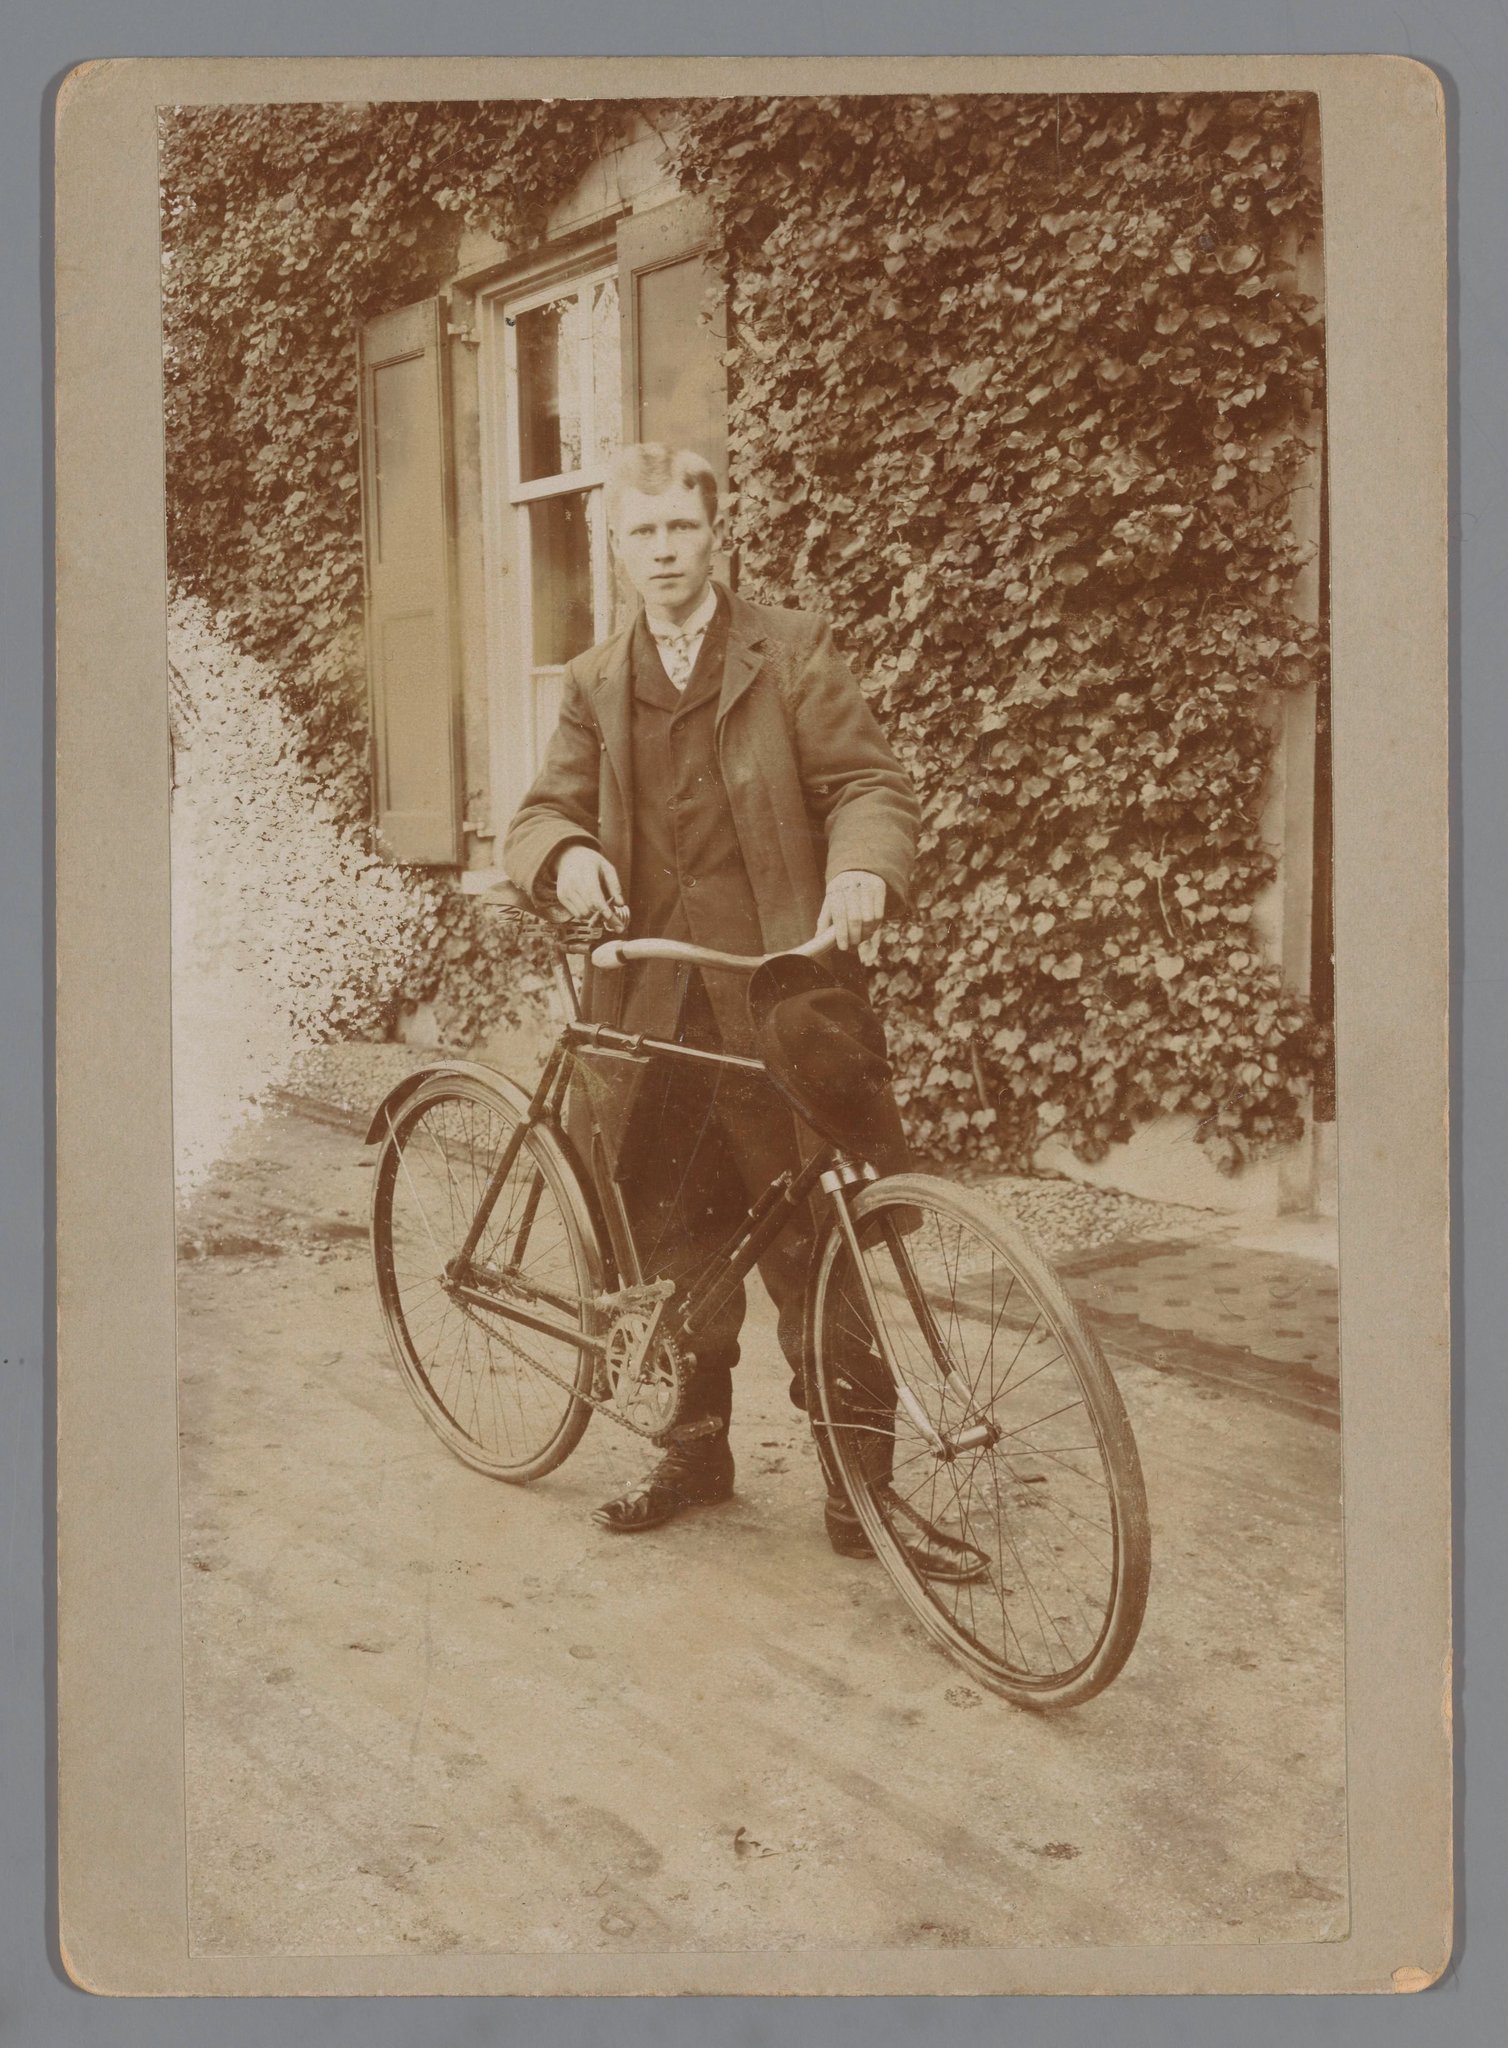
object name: photograph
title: Portret van een onbekende man met een fiets voor een huis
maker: Anonymous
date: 1890-1910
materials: cardboard, photographic support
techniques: gelatin silver print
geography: netherlands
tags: adult man, bicycle